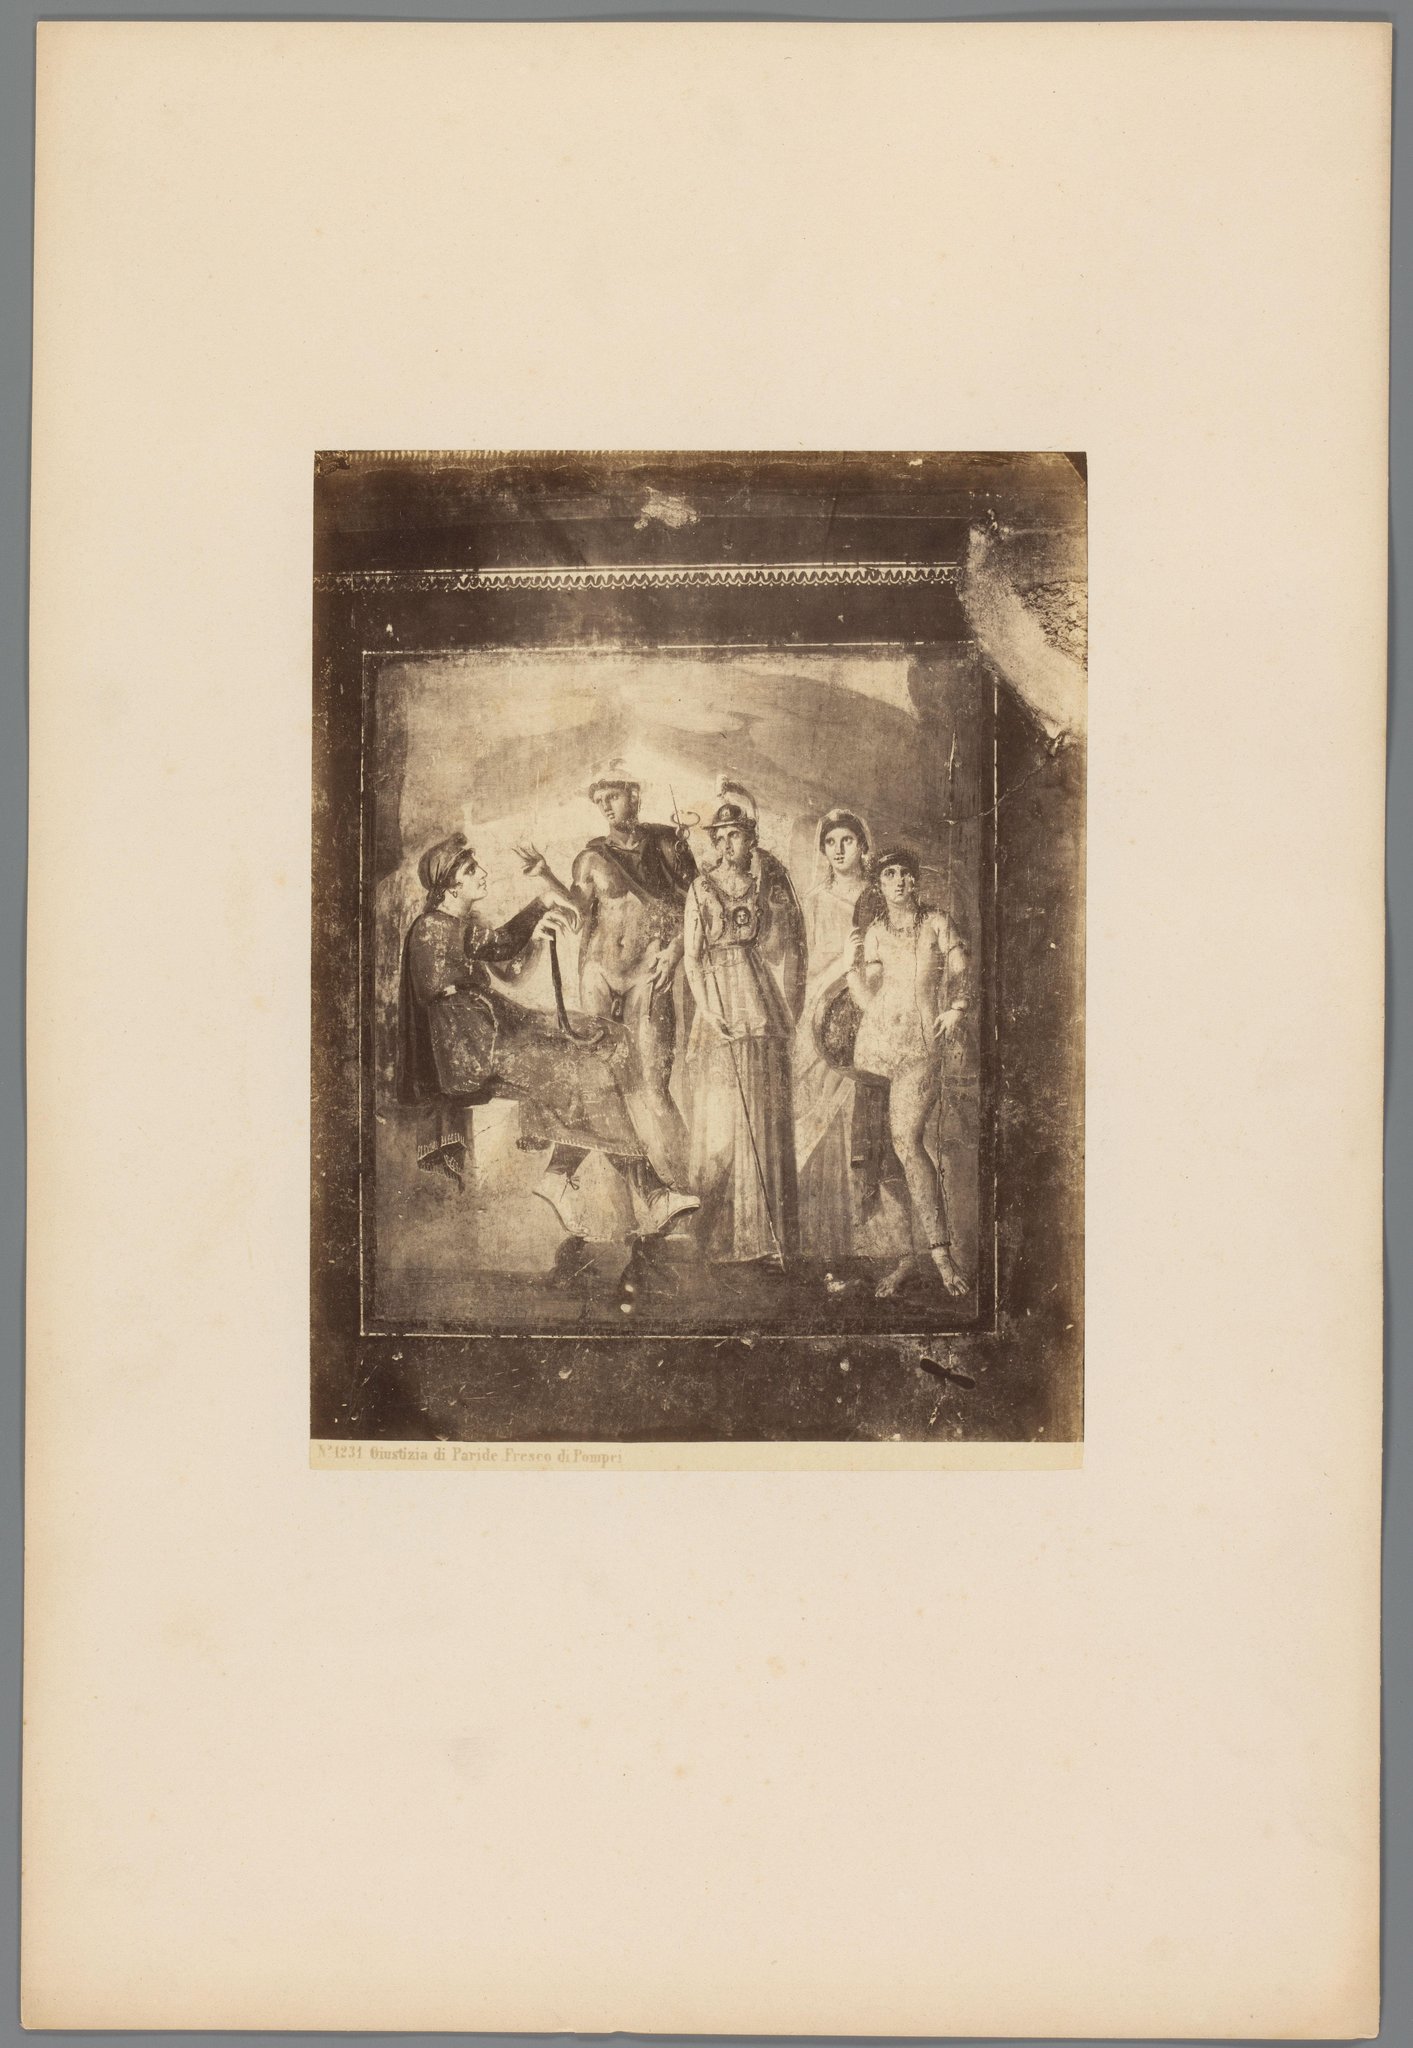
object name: reproduction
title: Giustizia di Paride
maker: Anonymous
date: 1851-1900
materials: cardboard, paper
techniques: albumen print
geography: pompeii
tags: wall-covering, pompeii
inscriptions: number: ‘No. 1231’